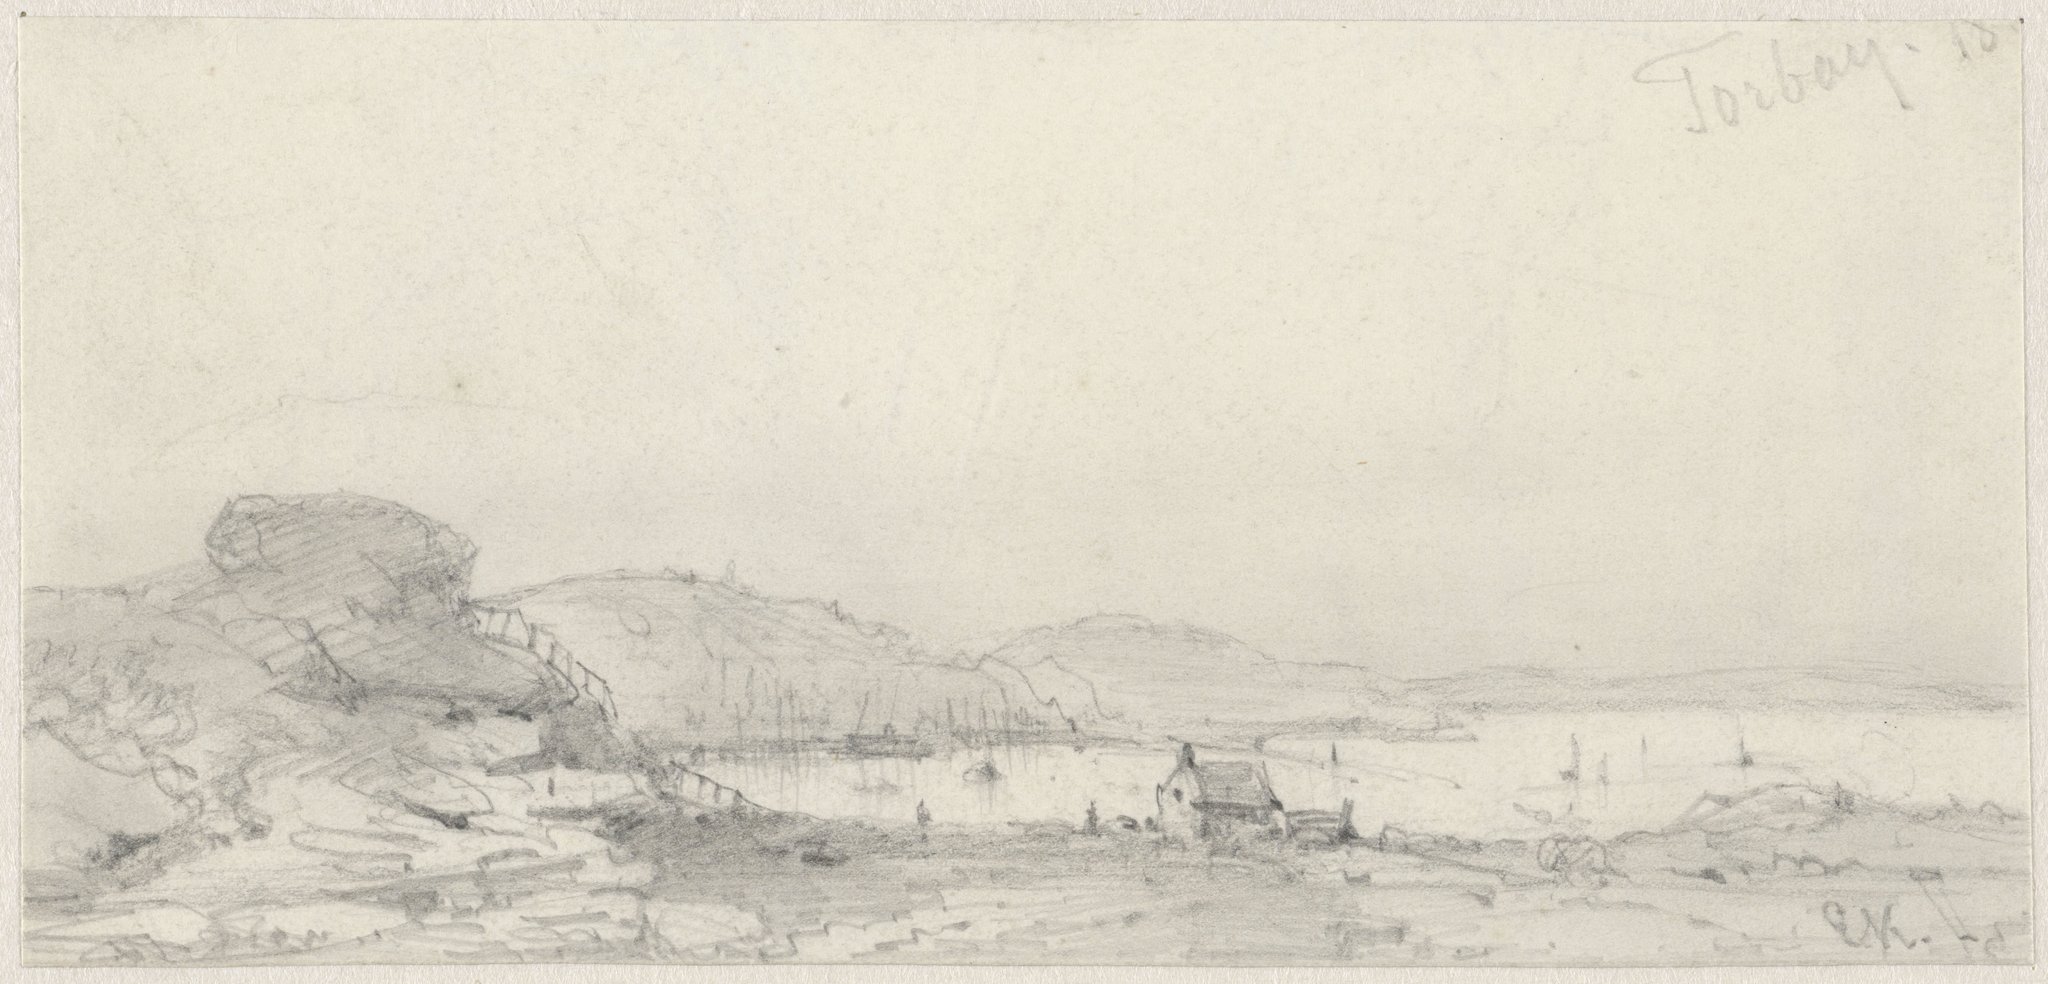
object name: drawing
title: Kustlandschap bij Torbay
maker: everhardus koster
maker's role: draughtsman, painter, print maker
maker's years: 1817-1892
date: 1827-1892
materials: paper, pencil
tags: coast, canada